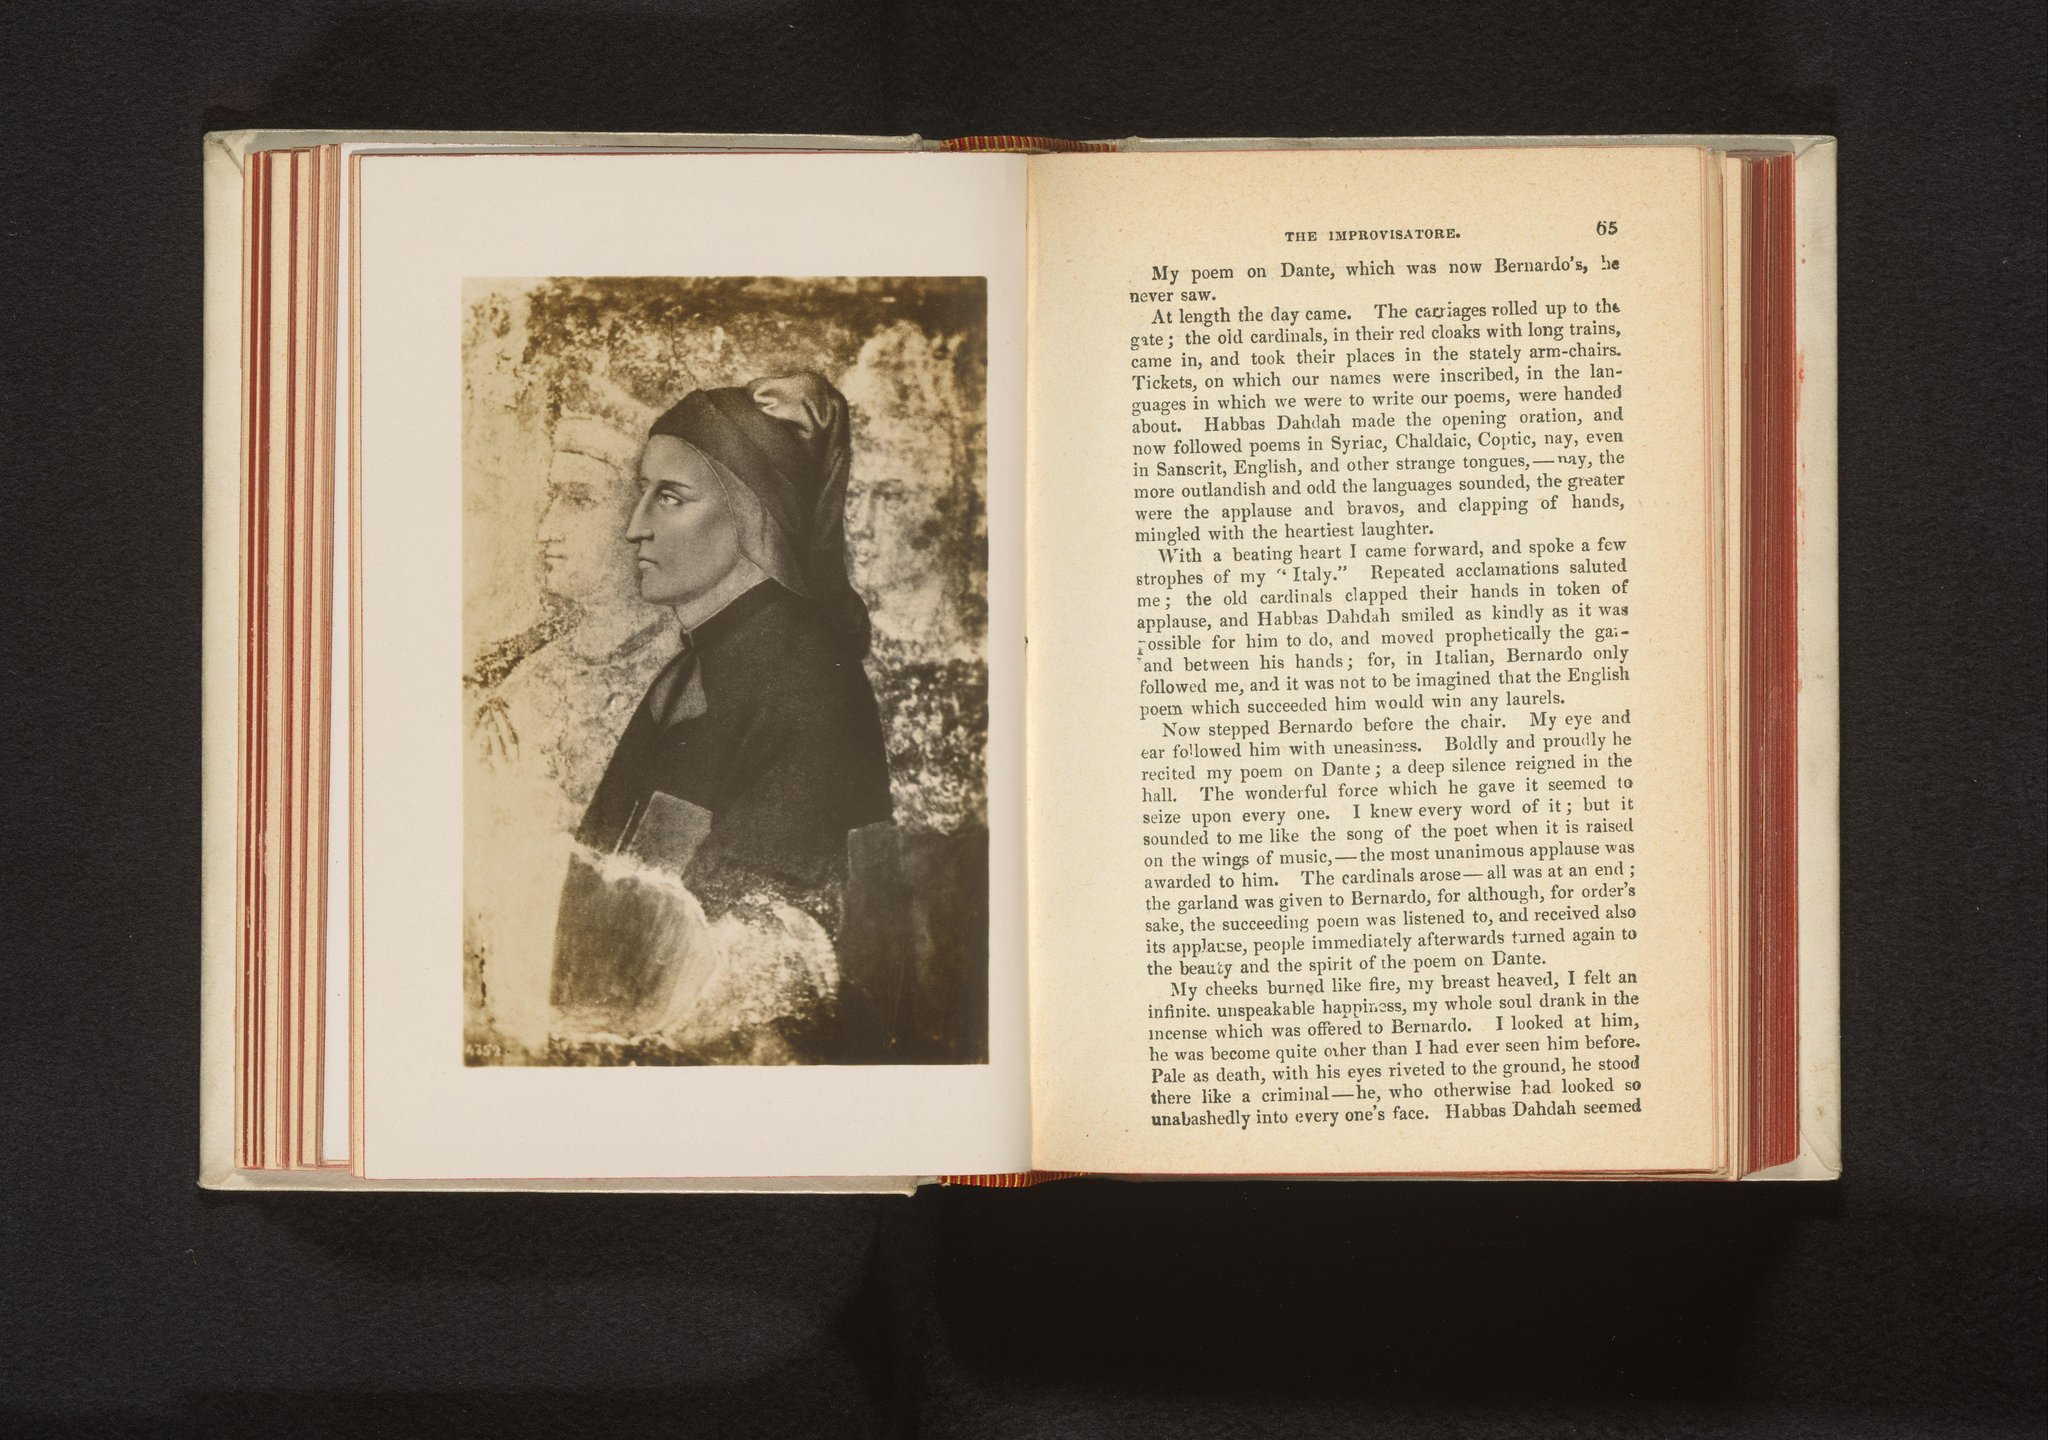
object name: photograph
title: Fotoreproductie van een fresco, voorstellende een portret van Dante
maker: Anonymous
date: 1870-1880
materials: photographic support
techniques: gelatin silver print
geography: palazzo del bargello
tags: dante